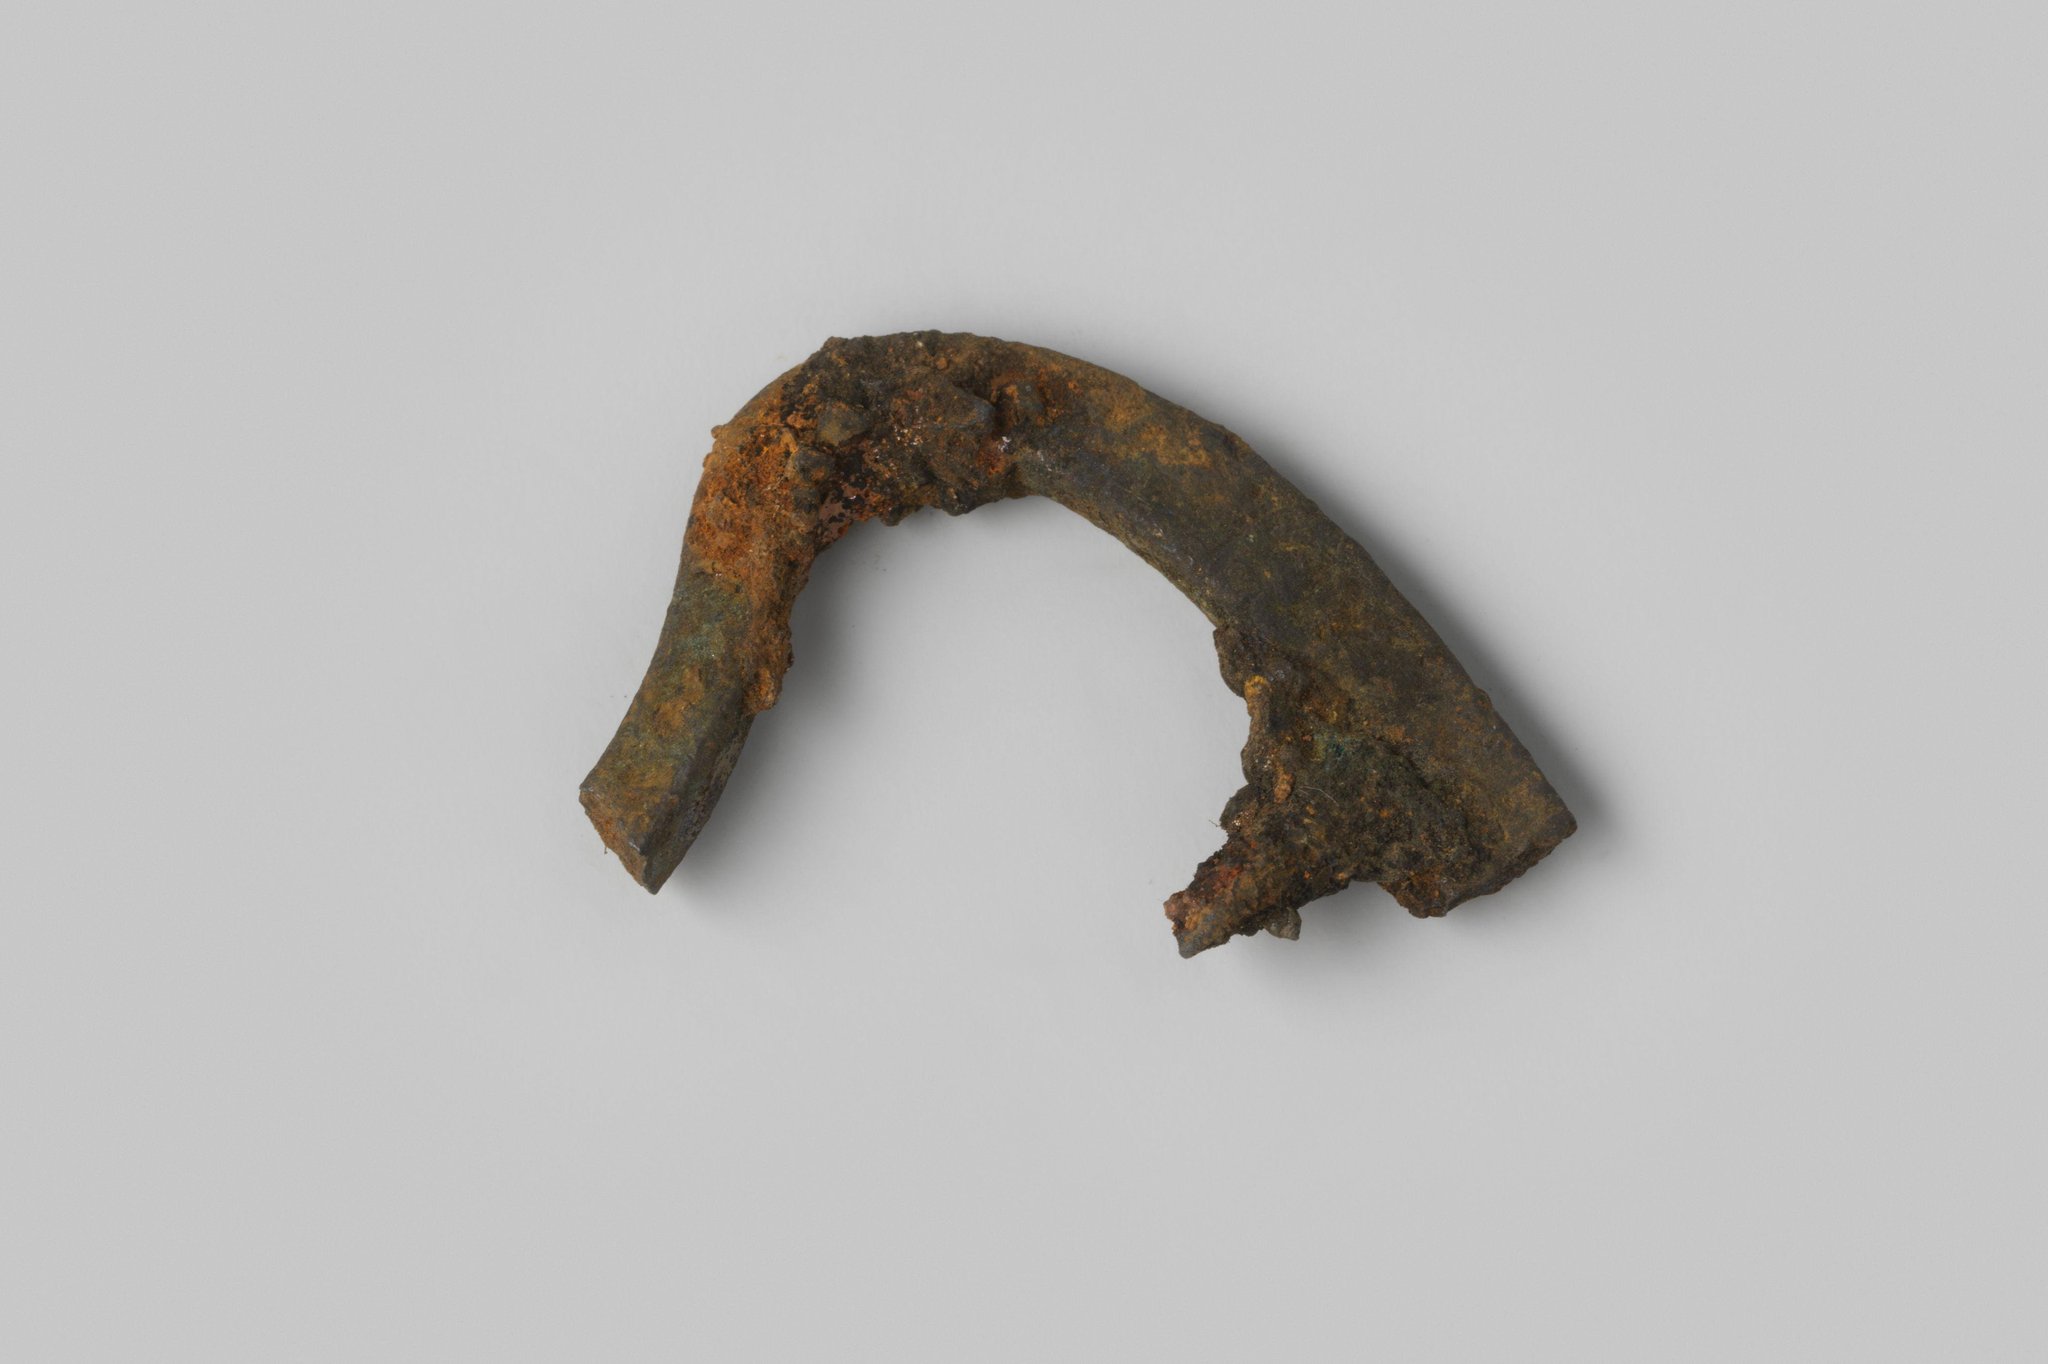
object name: buckle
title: Fragment van een gesp uit het wrak van de Oost-Indiëvaarder Hollandia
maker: Anonymous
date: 1700-1743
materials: copper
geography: netherlands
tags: verenigde oostindische compagnie, hollandia (schip), annet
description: Buckle, chape buckle, chape; fragm of single-pronged loop.